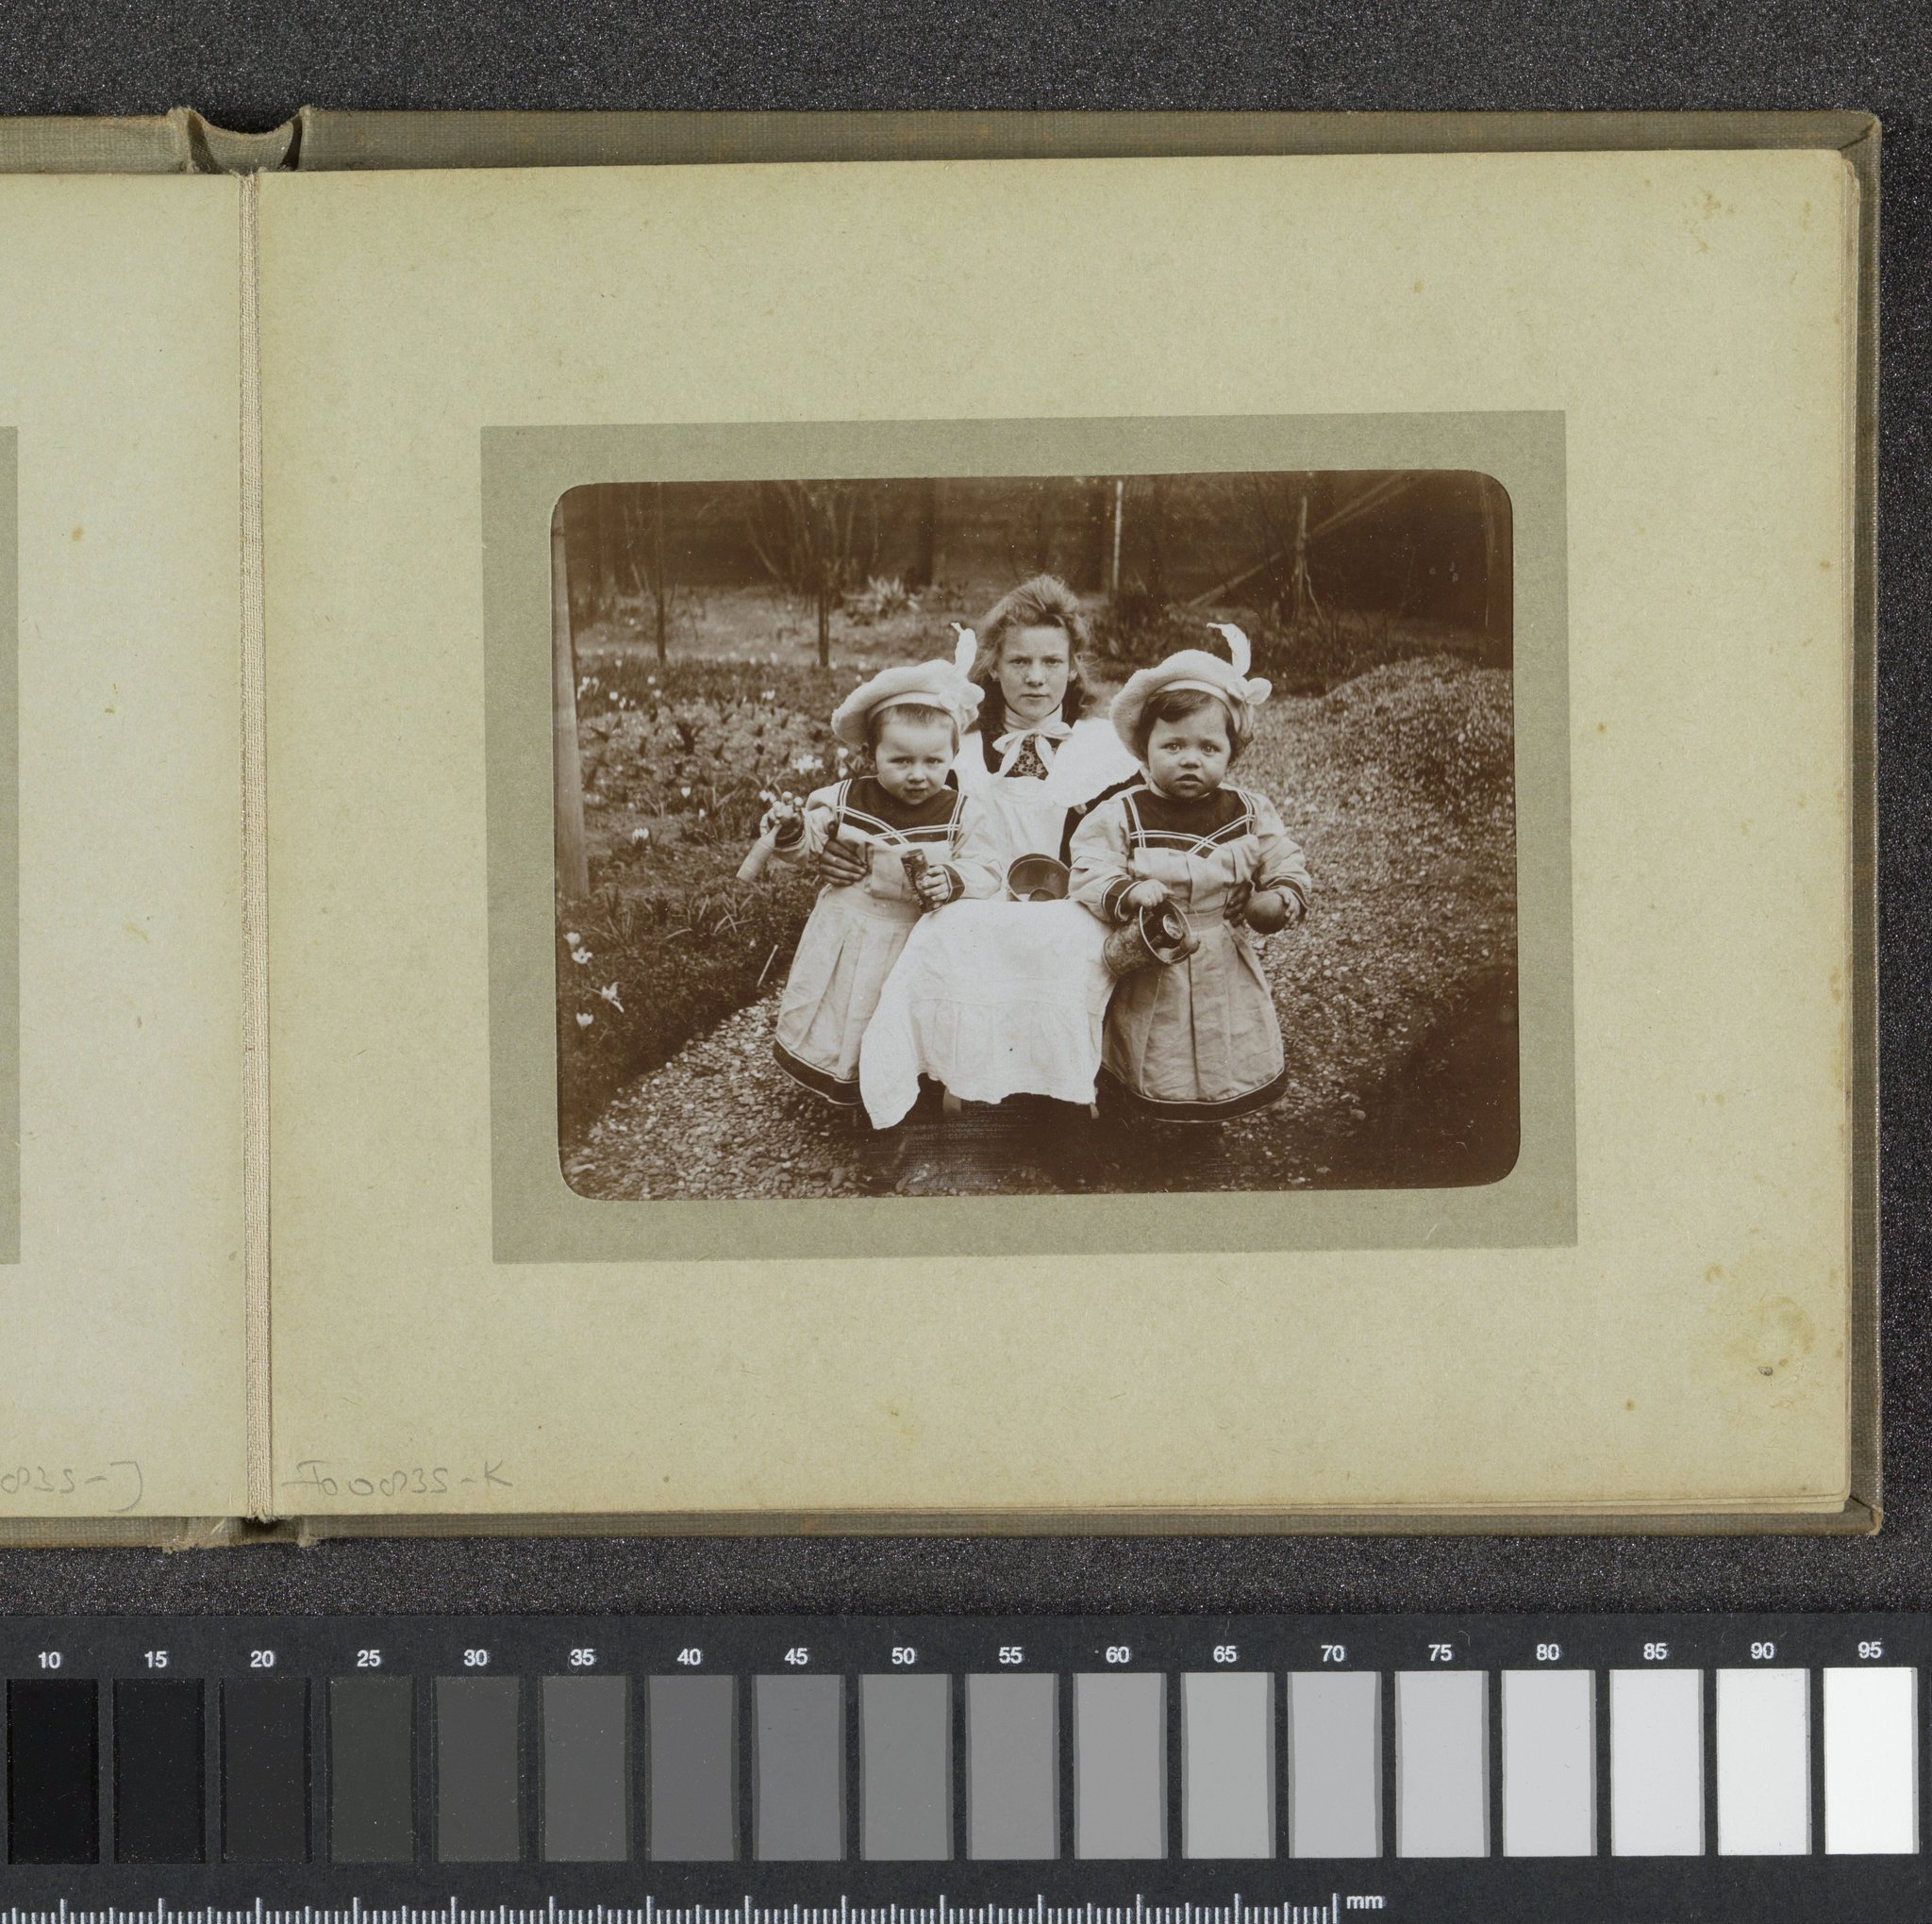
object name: photograph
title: Jonge vrouw en twee peuters met dezelfde jassen en baretten, waarschijnlijk de tweeling Ad en Johanna van der Kop met een familielid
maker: willem carel van der kop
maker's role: amateurfotograaf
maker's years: 1869-1924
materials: cardboard, paper, photographic support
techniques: collodion silver print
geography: schoonhoven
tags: twins, family life, head-gear: cap, tot, toddler ~ the ages of man, brothers or sisters (second degree family relationships)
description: Onderdeel van Fotoalbum met opnames van Ad, Johanna en Han van der Kop, hun moeder W.G. Hoogendijk en familieleden.